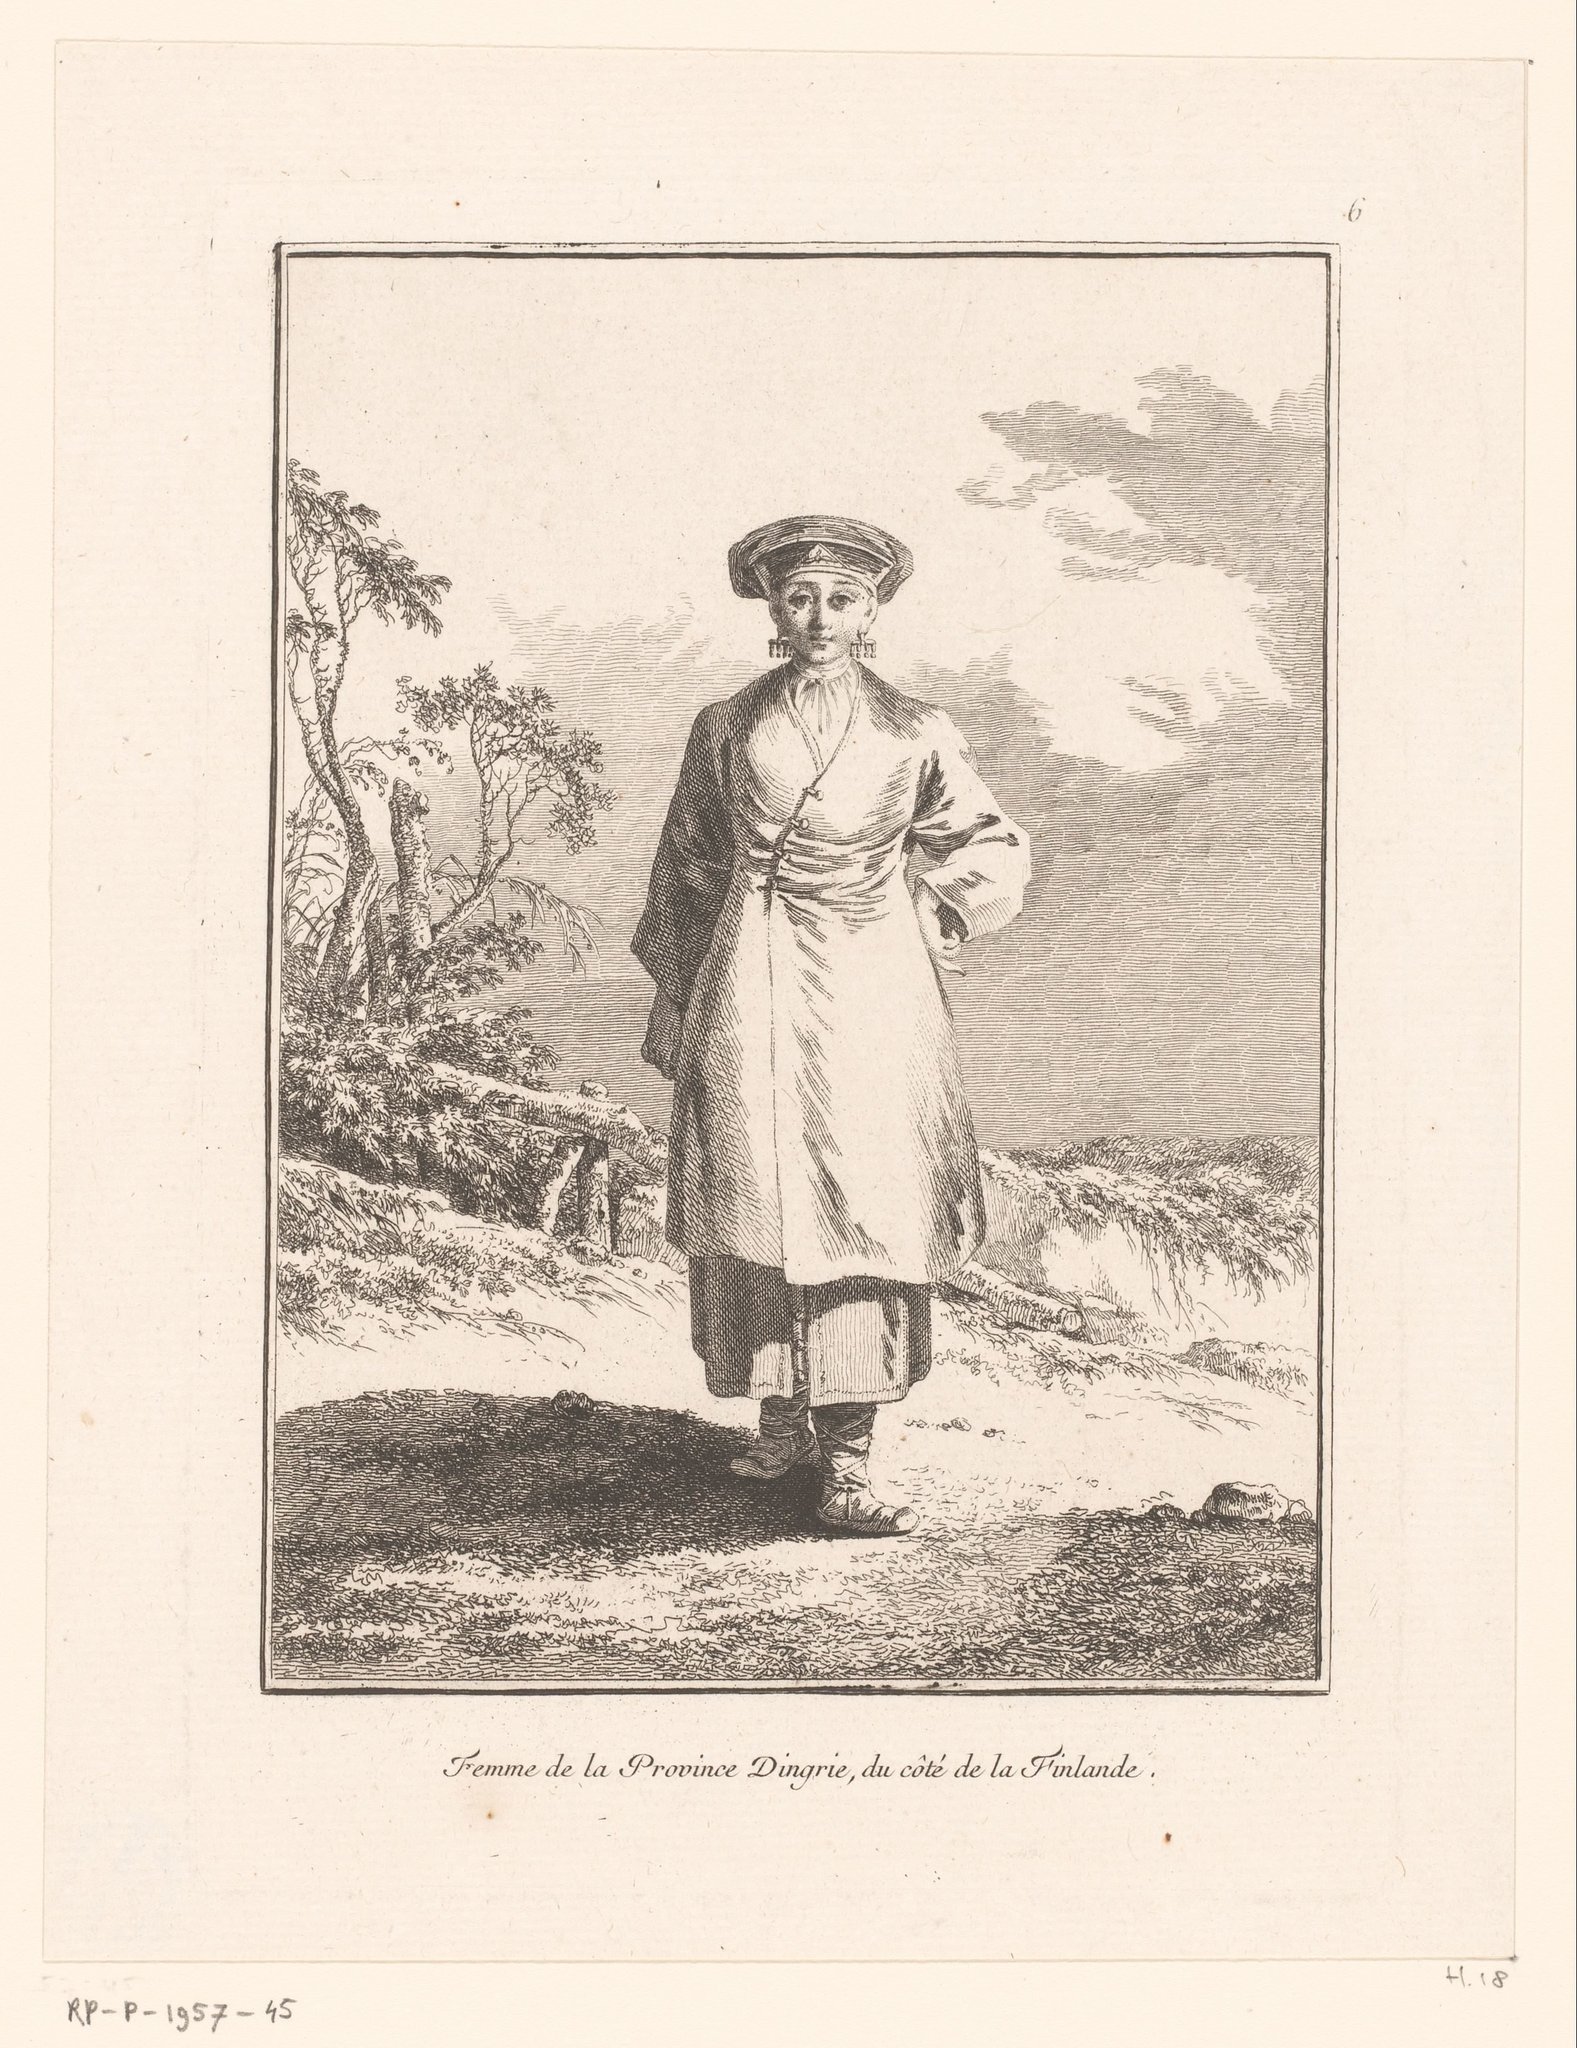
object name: print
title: Divers Ajustements et Usages de Russie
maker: jean baptist leprince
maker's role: draughtsman, print maker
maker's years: 1734-1781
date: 1744-1781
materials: paper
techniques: etching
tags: head-gear, folk costume, regional costume, ear-rings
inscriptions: collector's mark: Lugt 2228, collector's mark: ‘Douane Centrale. Exportation Paris’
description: Maakt deel uit van een tiendelige serie met Russische tradities en gebruiken.